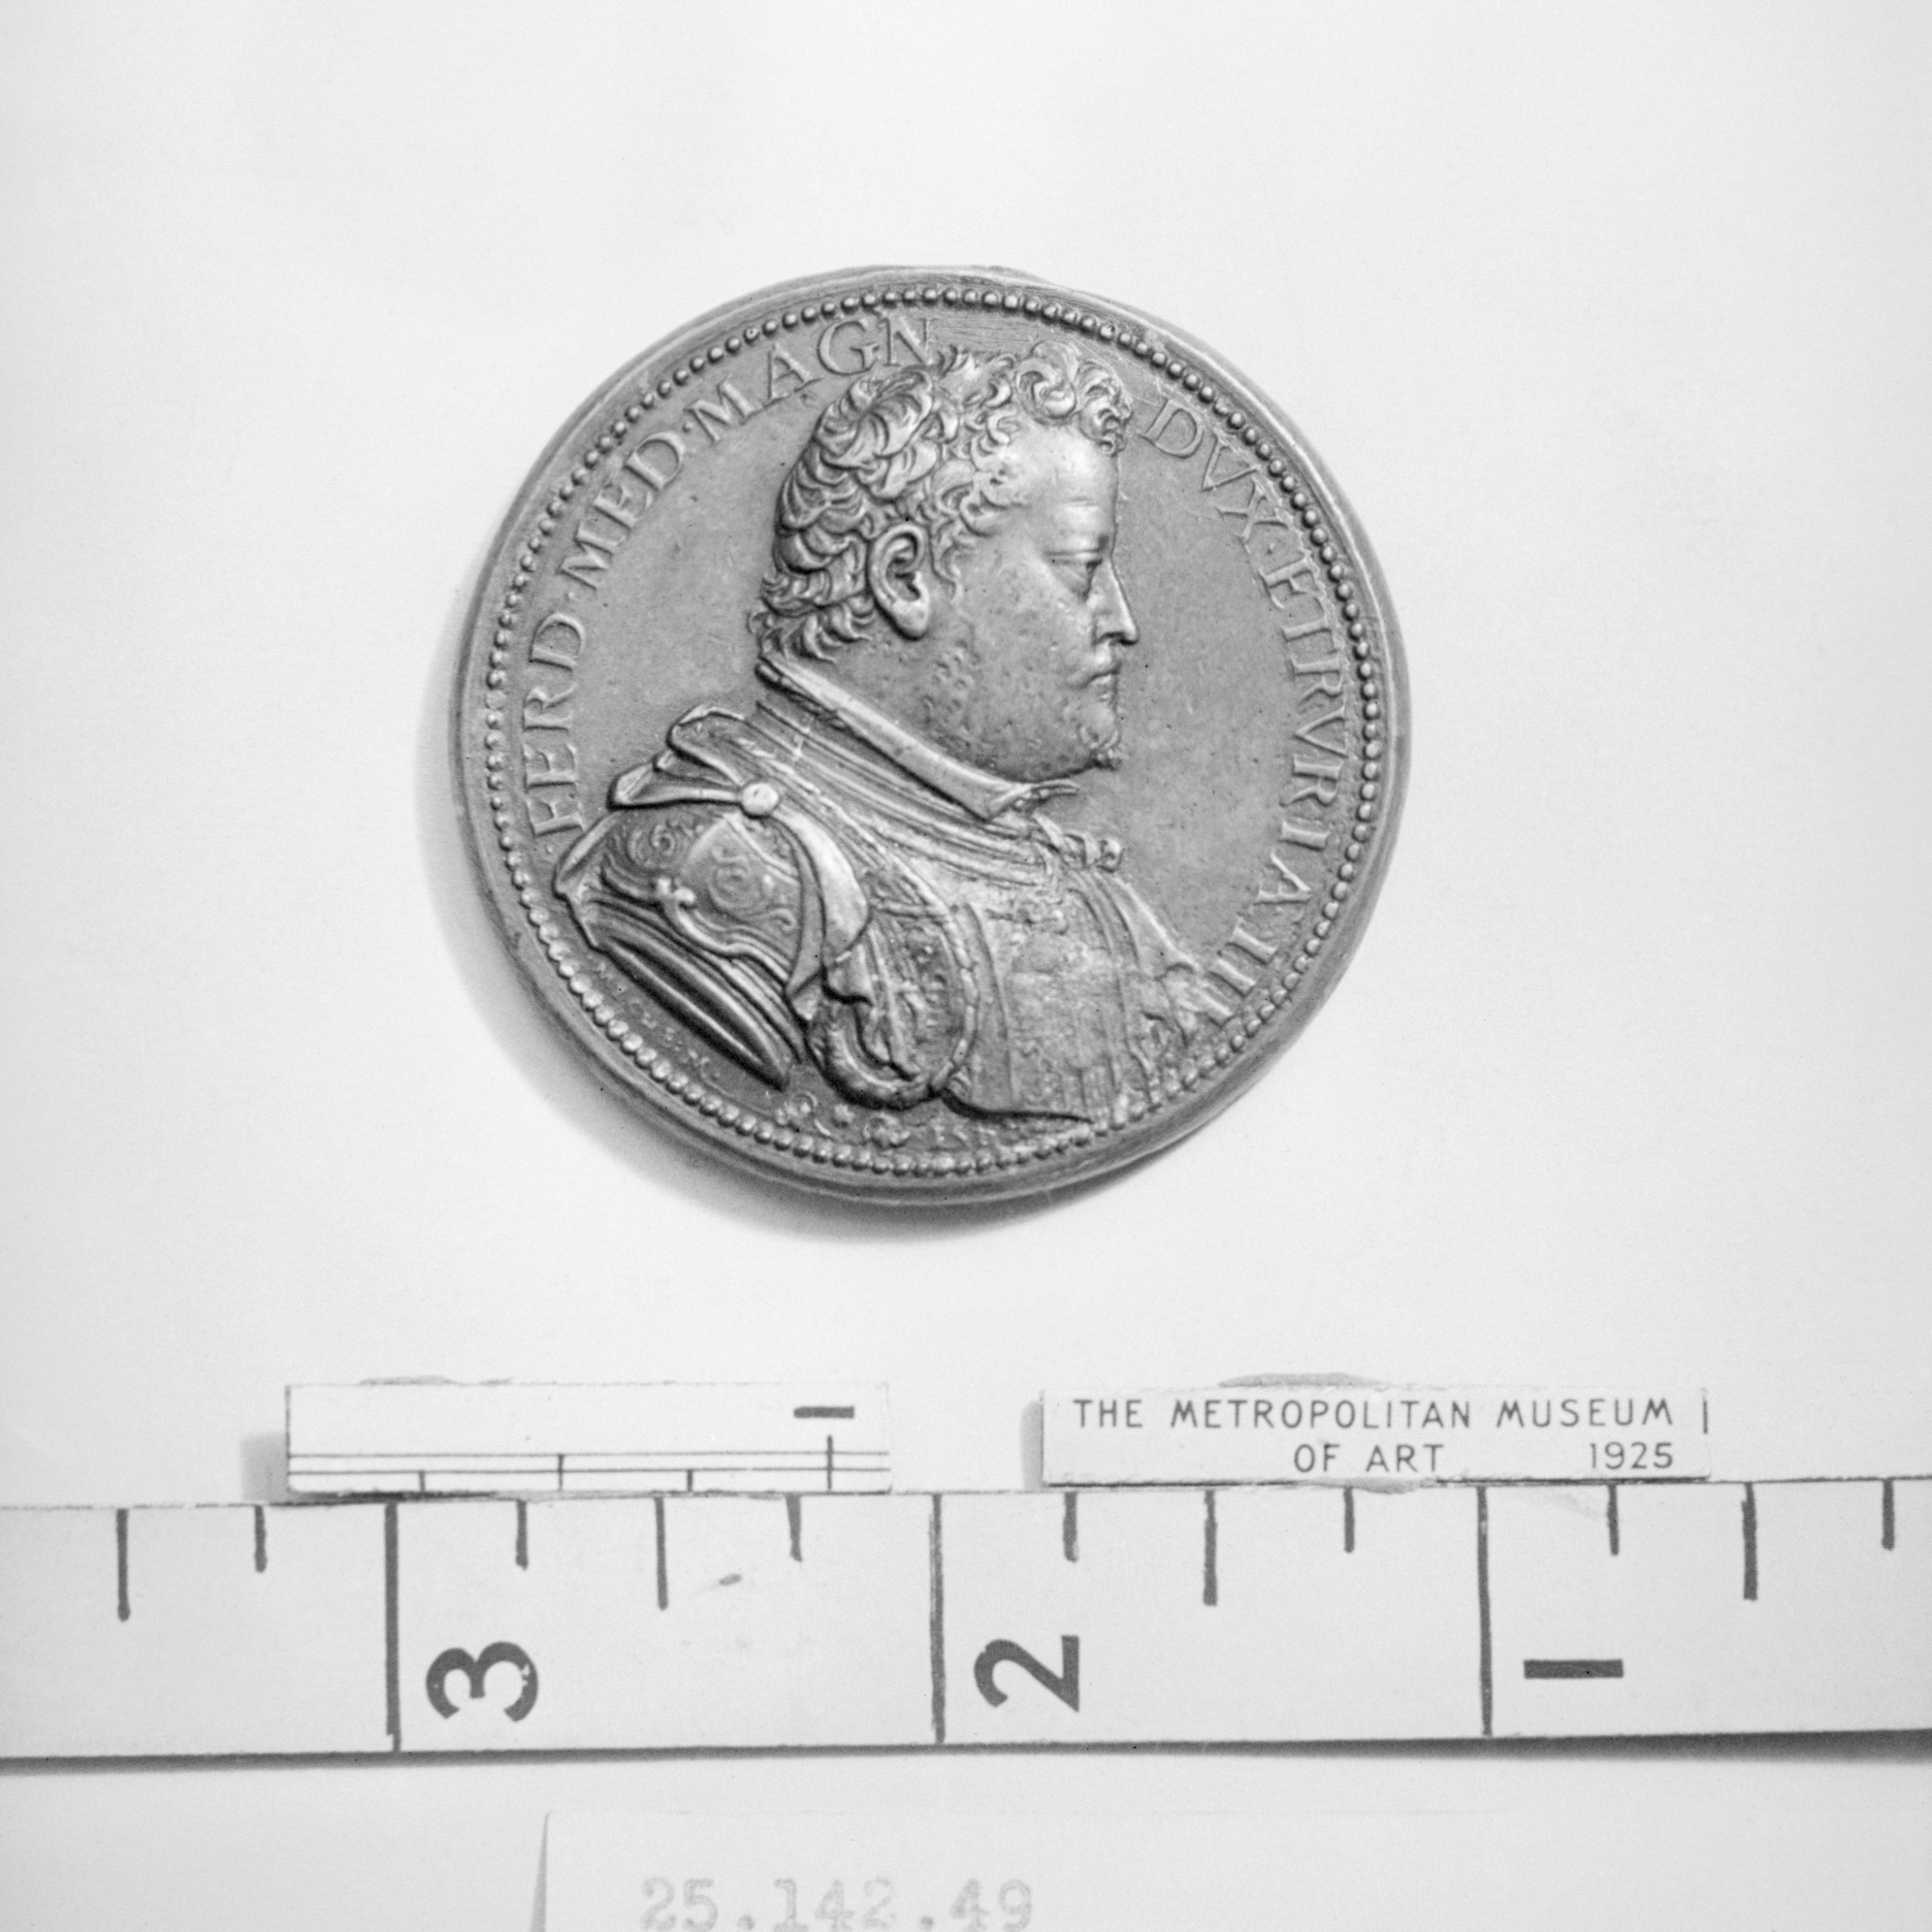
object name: medal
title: Ferdinand I de'Medici, Grand Duke of Tuscany (1587–1609)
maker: michele mazzafirri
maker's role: artist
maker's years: 1525-1597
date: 1588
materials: bronze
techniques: casting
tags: men,profiles,insects